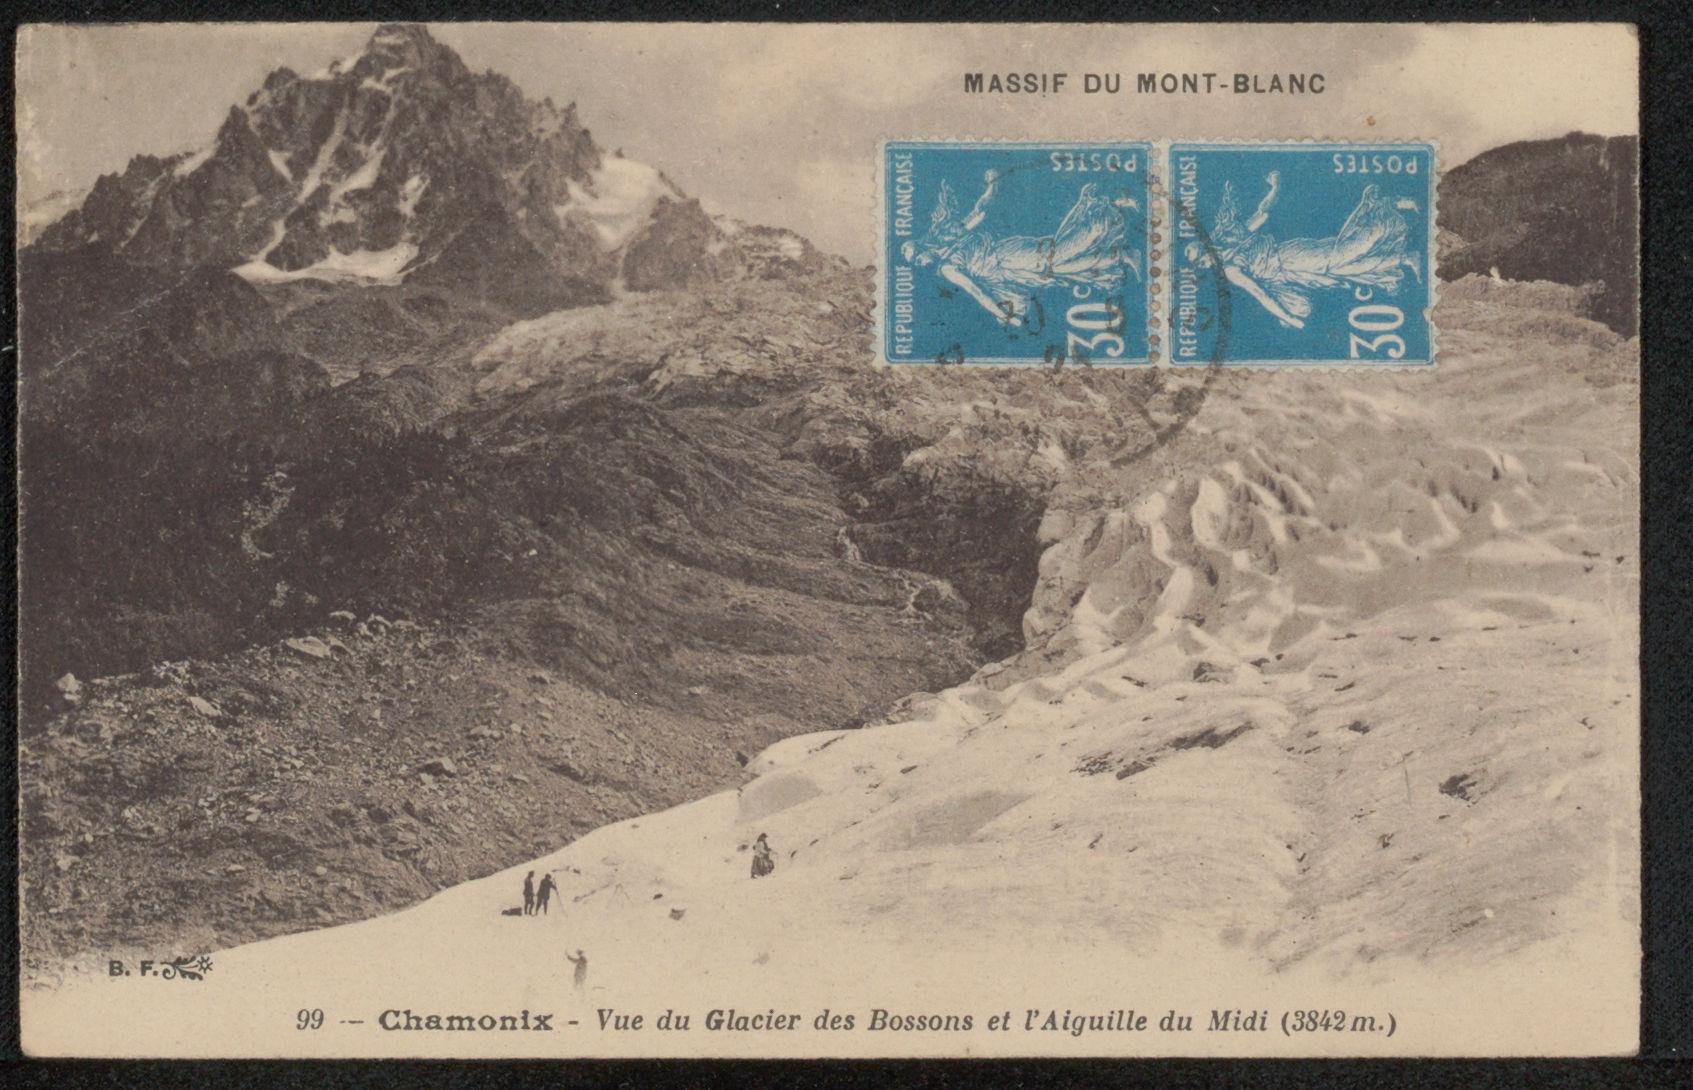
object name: ansichtkaart, prentbriefkaart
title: Prentbriefkaart aan Philip Zilcken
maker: rose imel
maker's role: draughtsman, painter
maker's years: 1901-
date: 1925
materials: cardboard, ink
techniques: photograph, pen, writing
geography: paris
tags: the hague, painter, draughtsman, philip zilcken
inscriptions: collector's mark: ‘RPK’